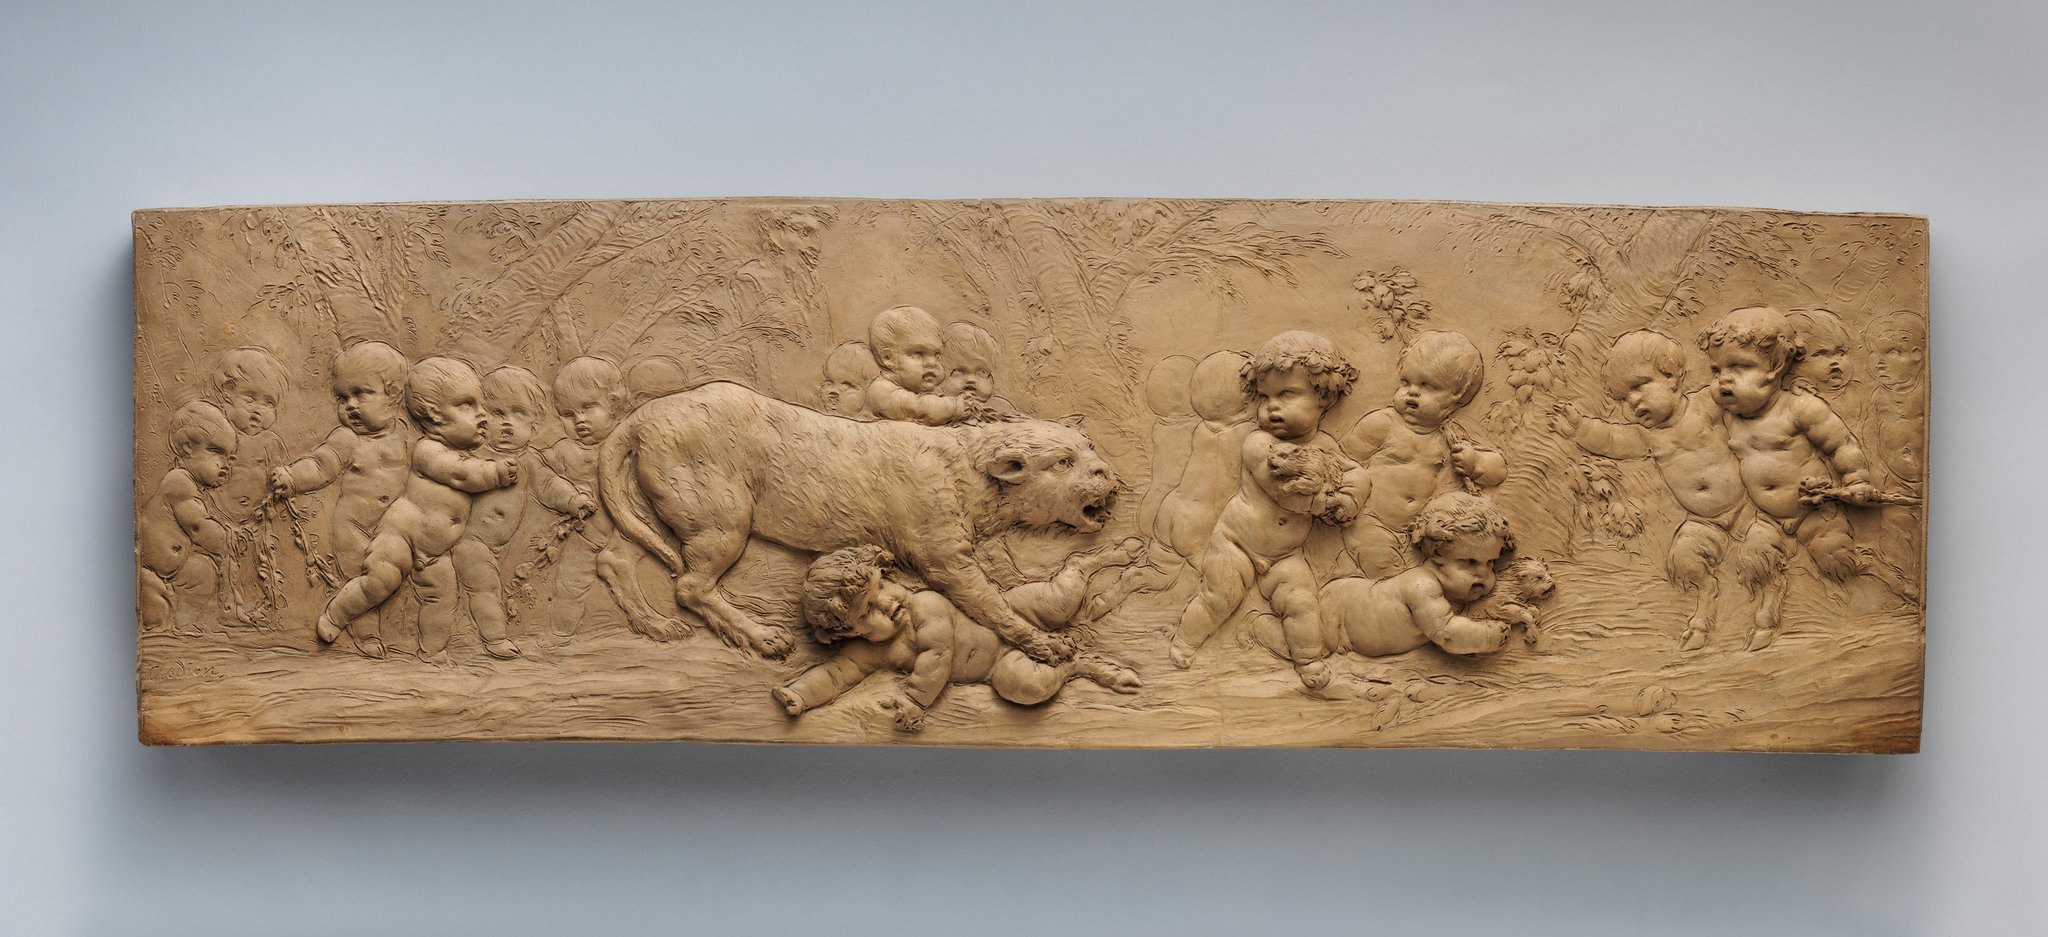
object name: relief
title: Children and Satyr Children with a Pantheress and Her Cubs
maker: clodion (claude michel)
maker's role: artist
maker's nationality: french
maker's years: 1738-1814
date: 1781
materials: terracotta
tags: animals,children,satyrs